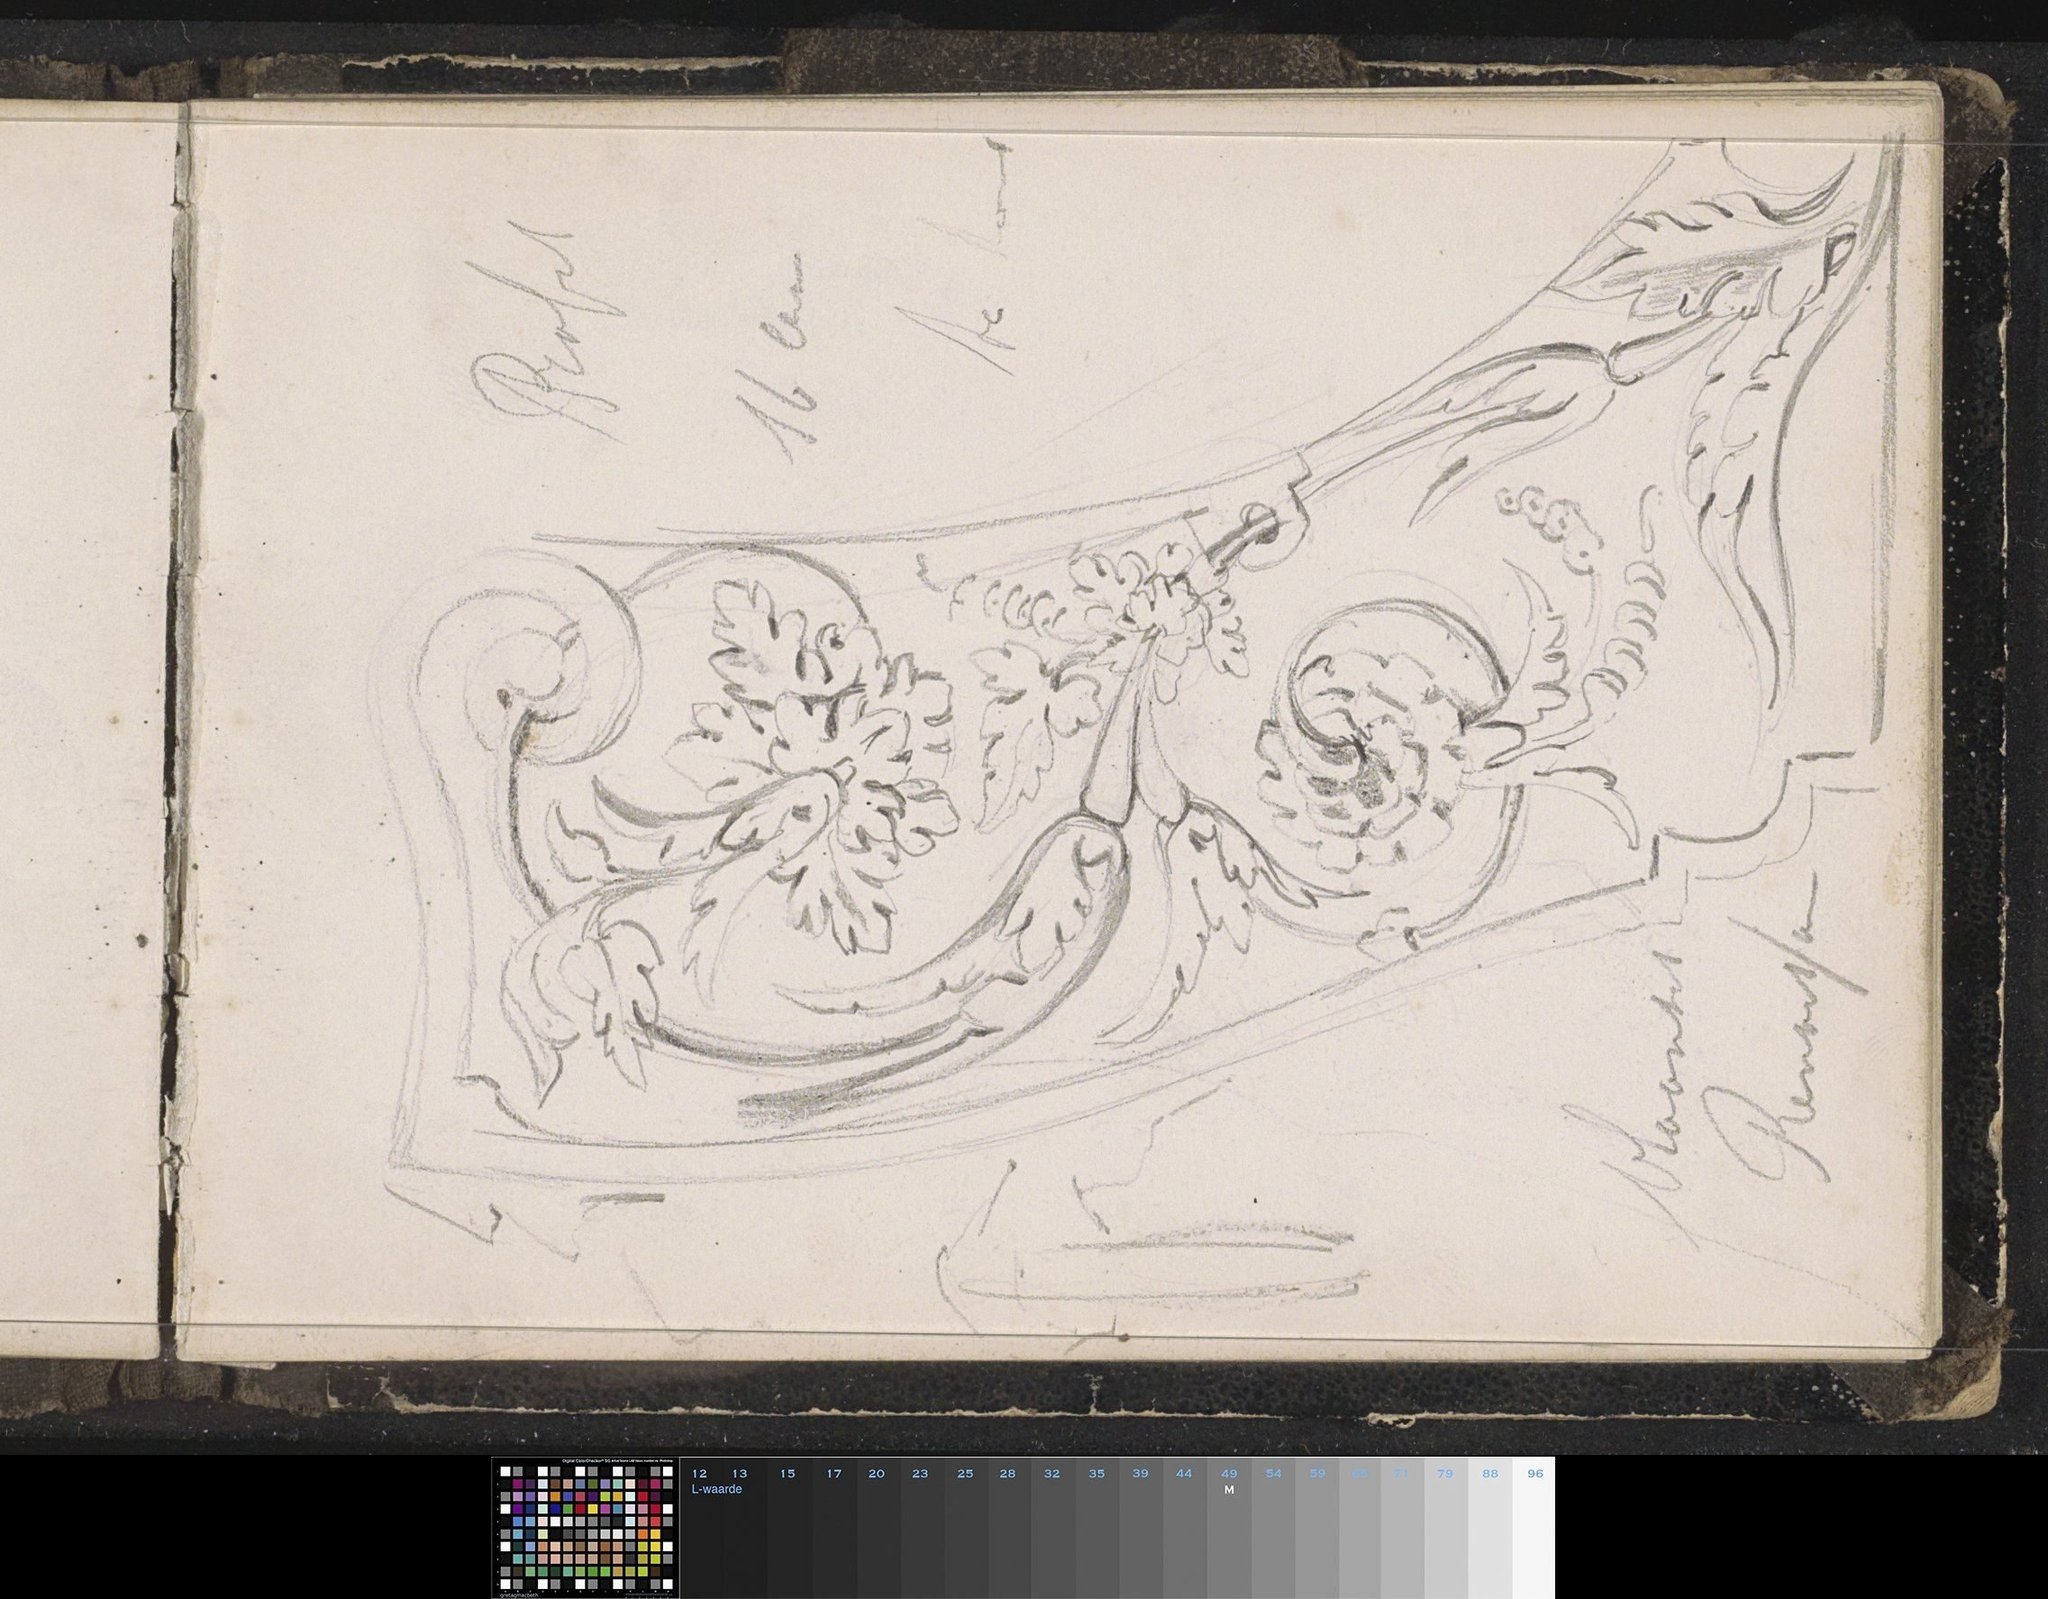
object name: sketchbook leaf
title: Floraal ornament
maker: jac van looij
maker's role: draughtsman, painter, print maker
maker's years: 1855-1930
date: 1877-1880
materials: paper, pencil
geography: amsterdam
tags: flowers ~ ornament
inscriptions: annotation: ‘Profiel/ 16 cm/ te kort/ vlaamsch/ Renaissan’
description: Blad 12 recto uit een schetsboek met 27 bladen.